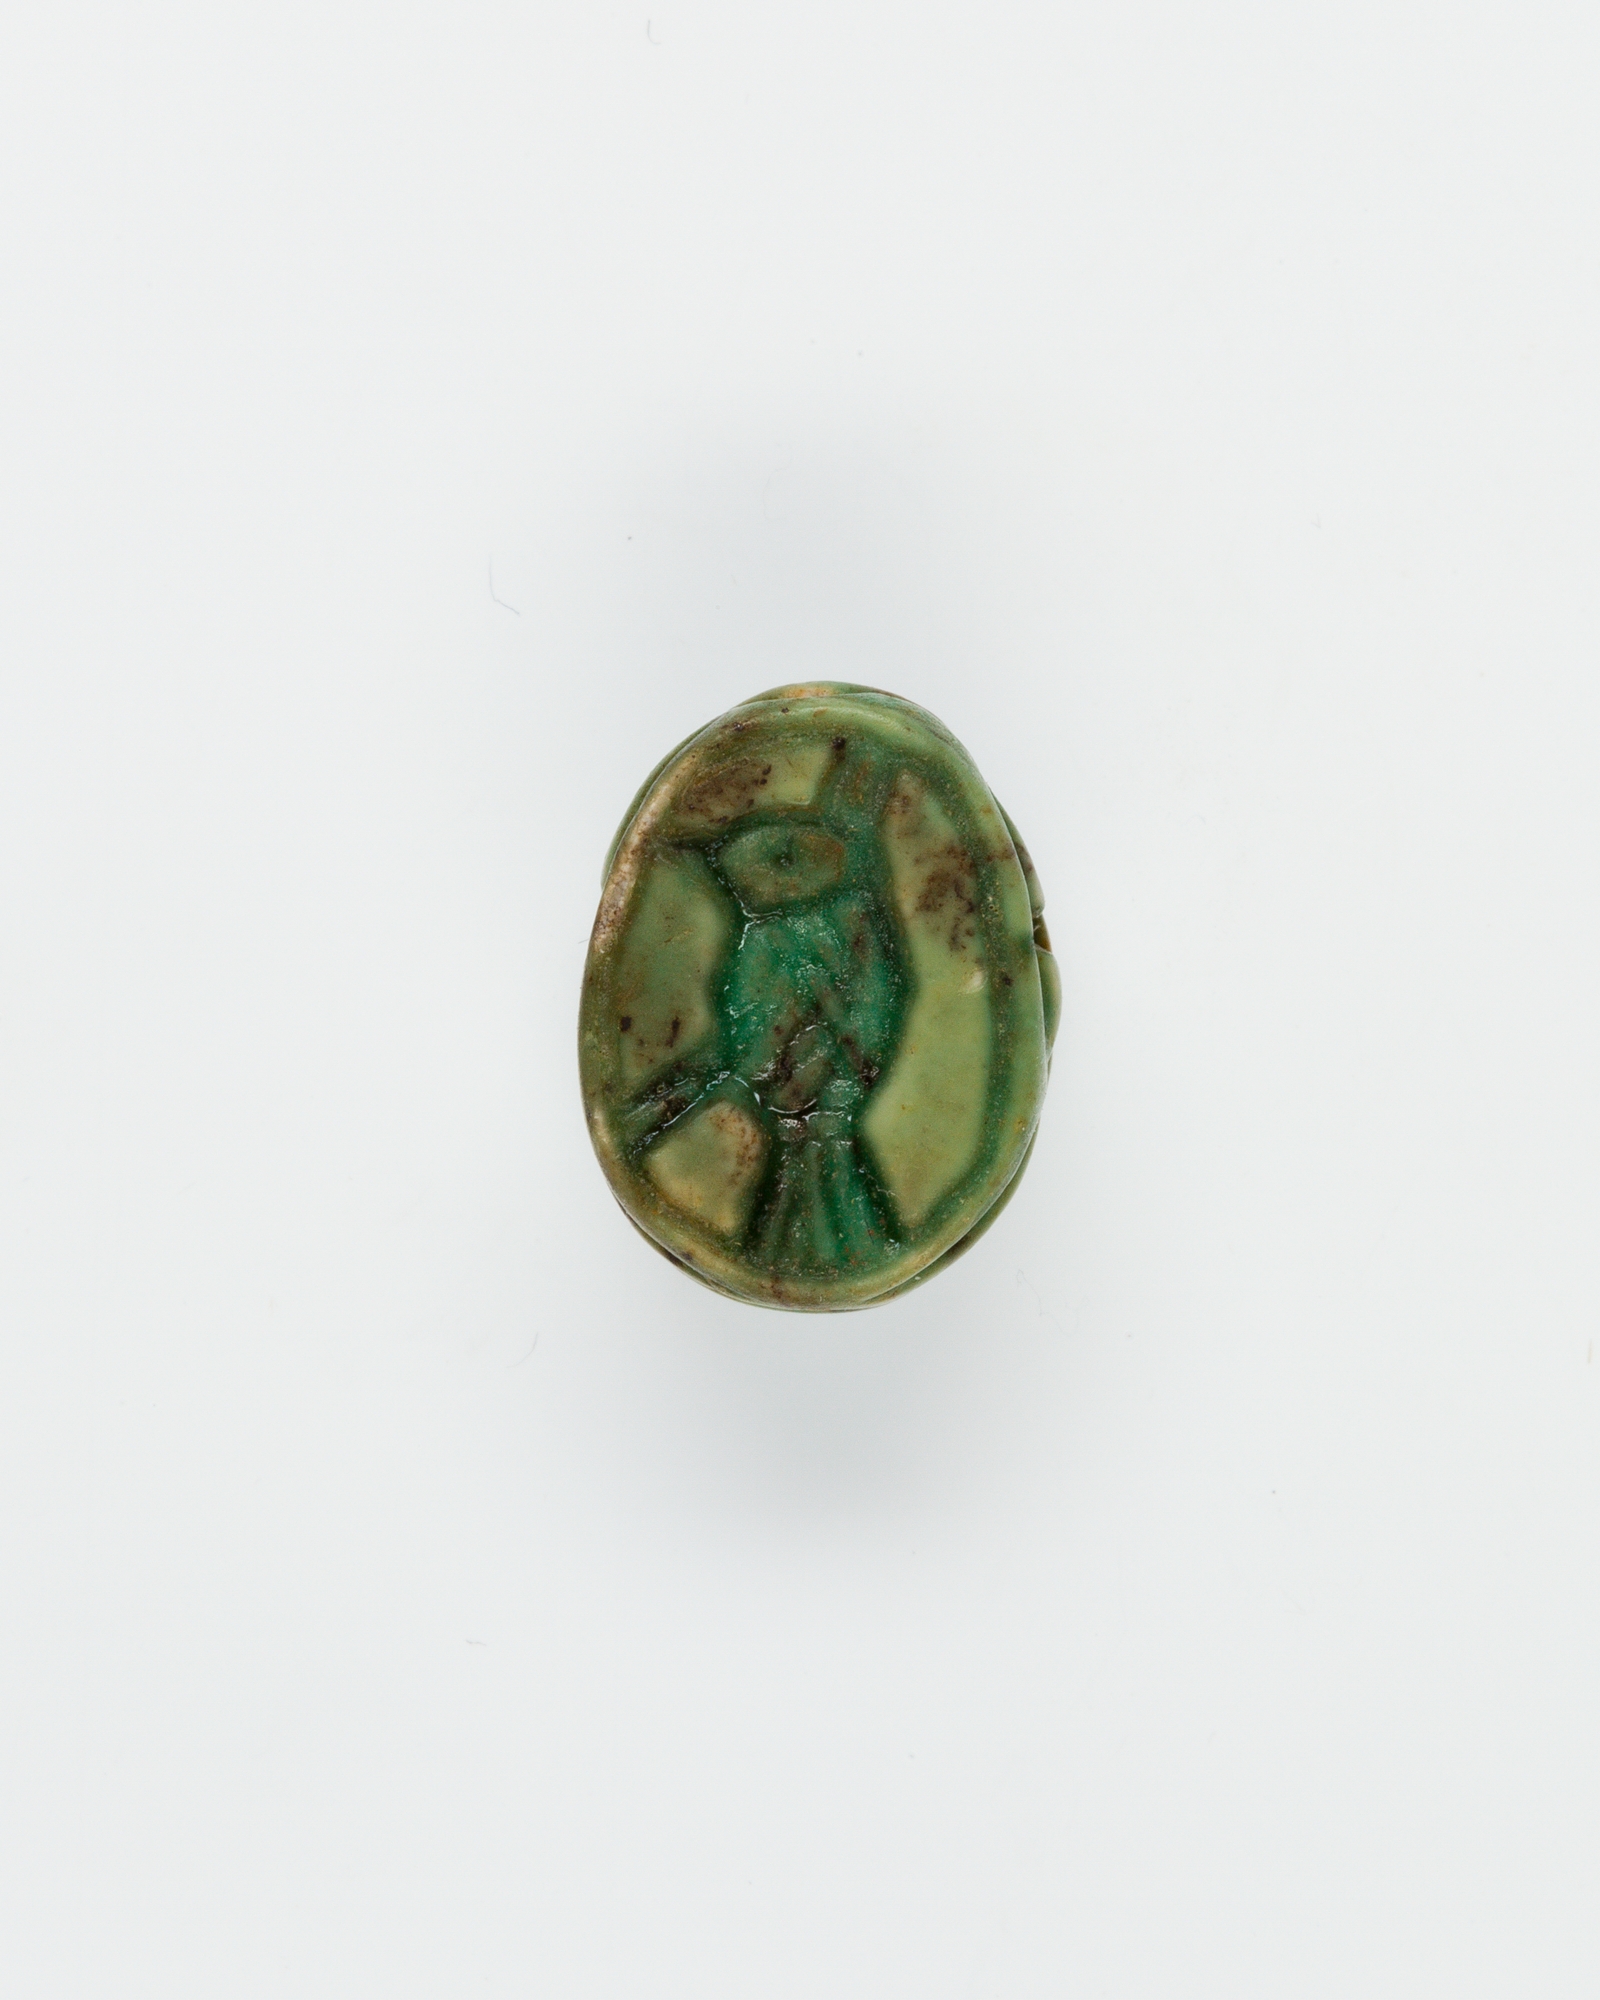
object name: scarab, bird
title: Scarab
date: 1492-1479 BCE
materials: stone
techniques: glazing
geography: egypt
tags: scarabs